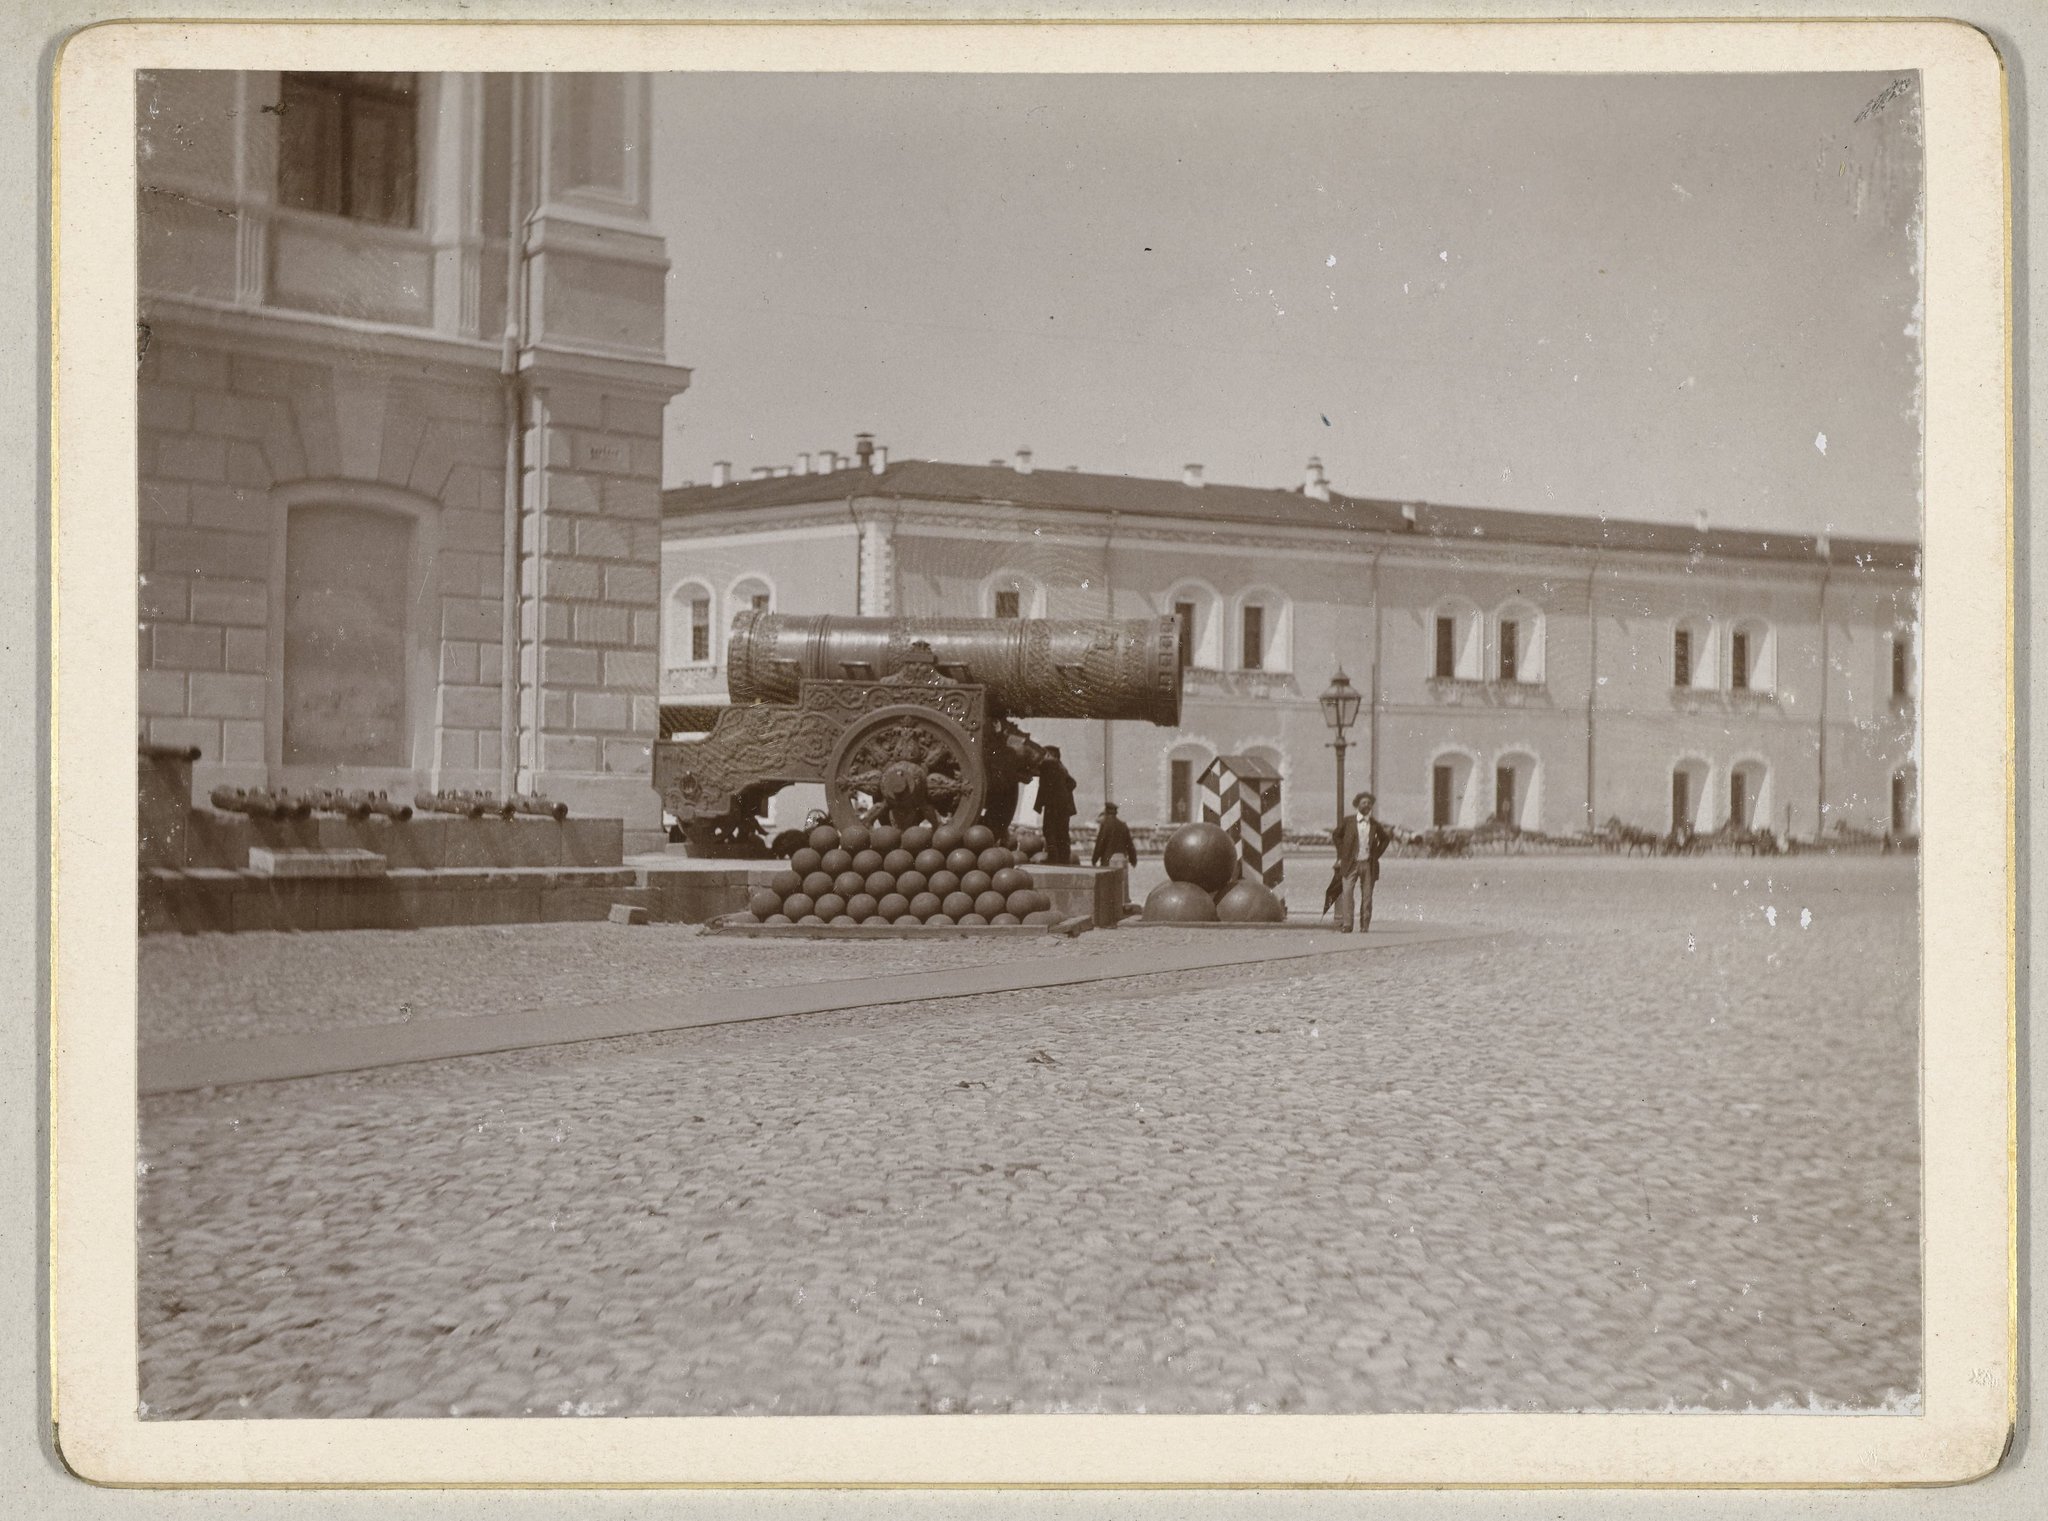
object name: photograph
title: Moscow, groot kanon op het Kremlin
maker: henry pauw van wieldrecht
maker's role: fotograaf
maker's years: 1863-1912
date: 1898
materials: paper, photographic support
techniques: albumen print